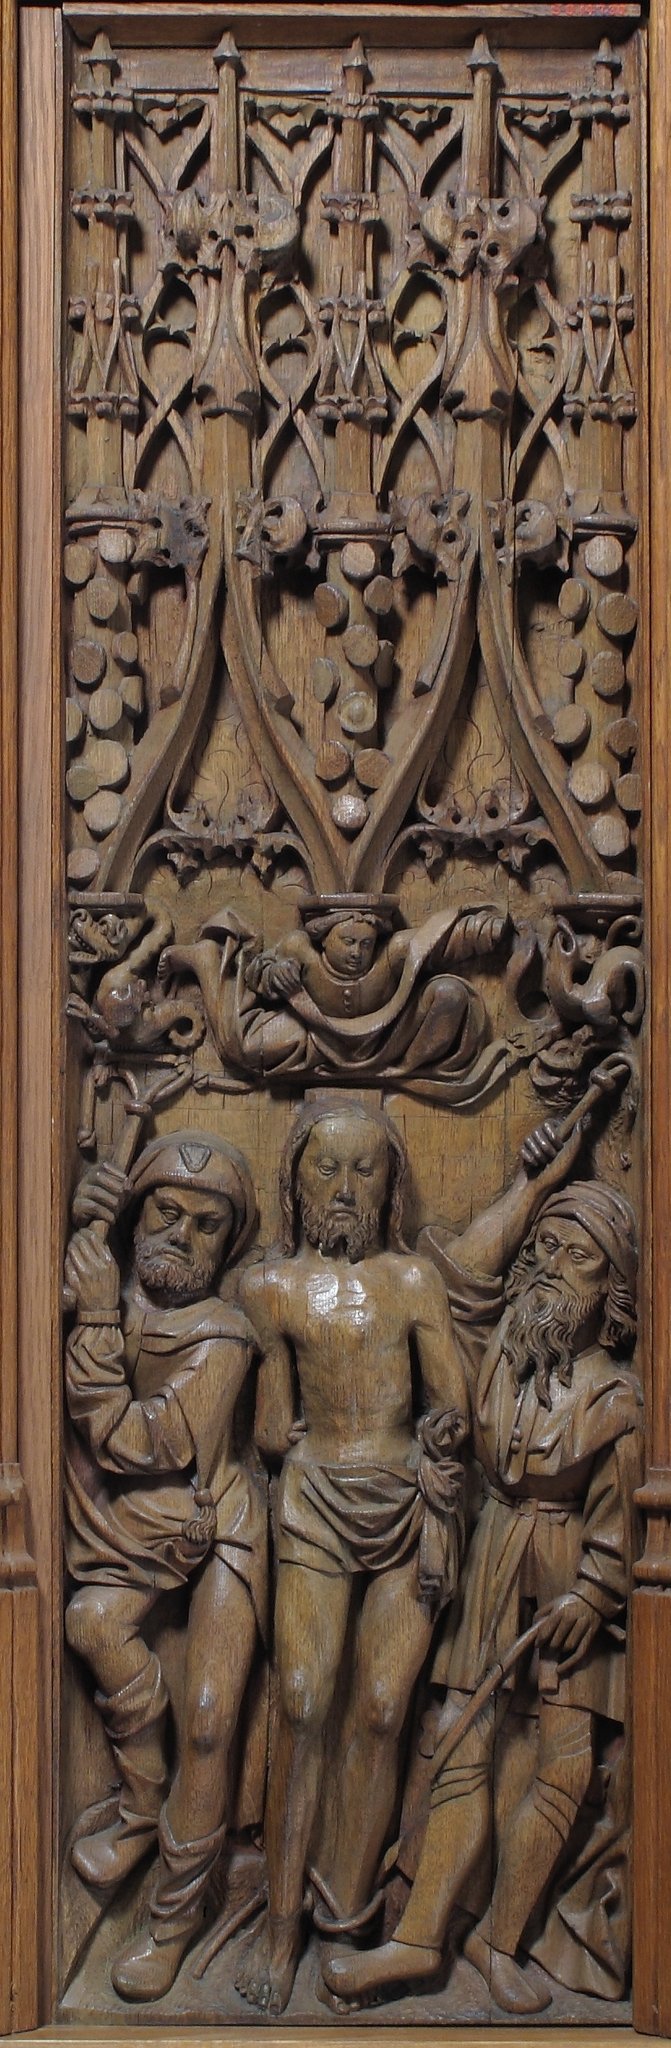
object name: panel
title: Panel with the Scourging of Christ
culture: french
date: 1500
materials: wood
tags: men,christ